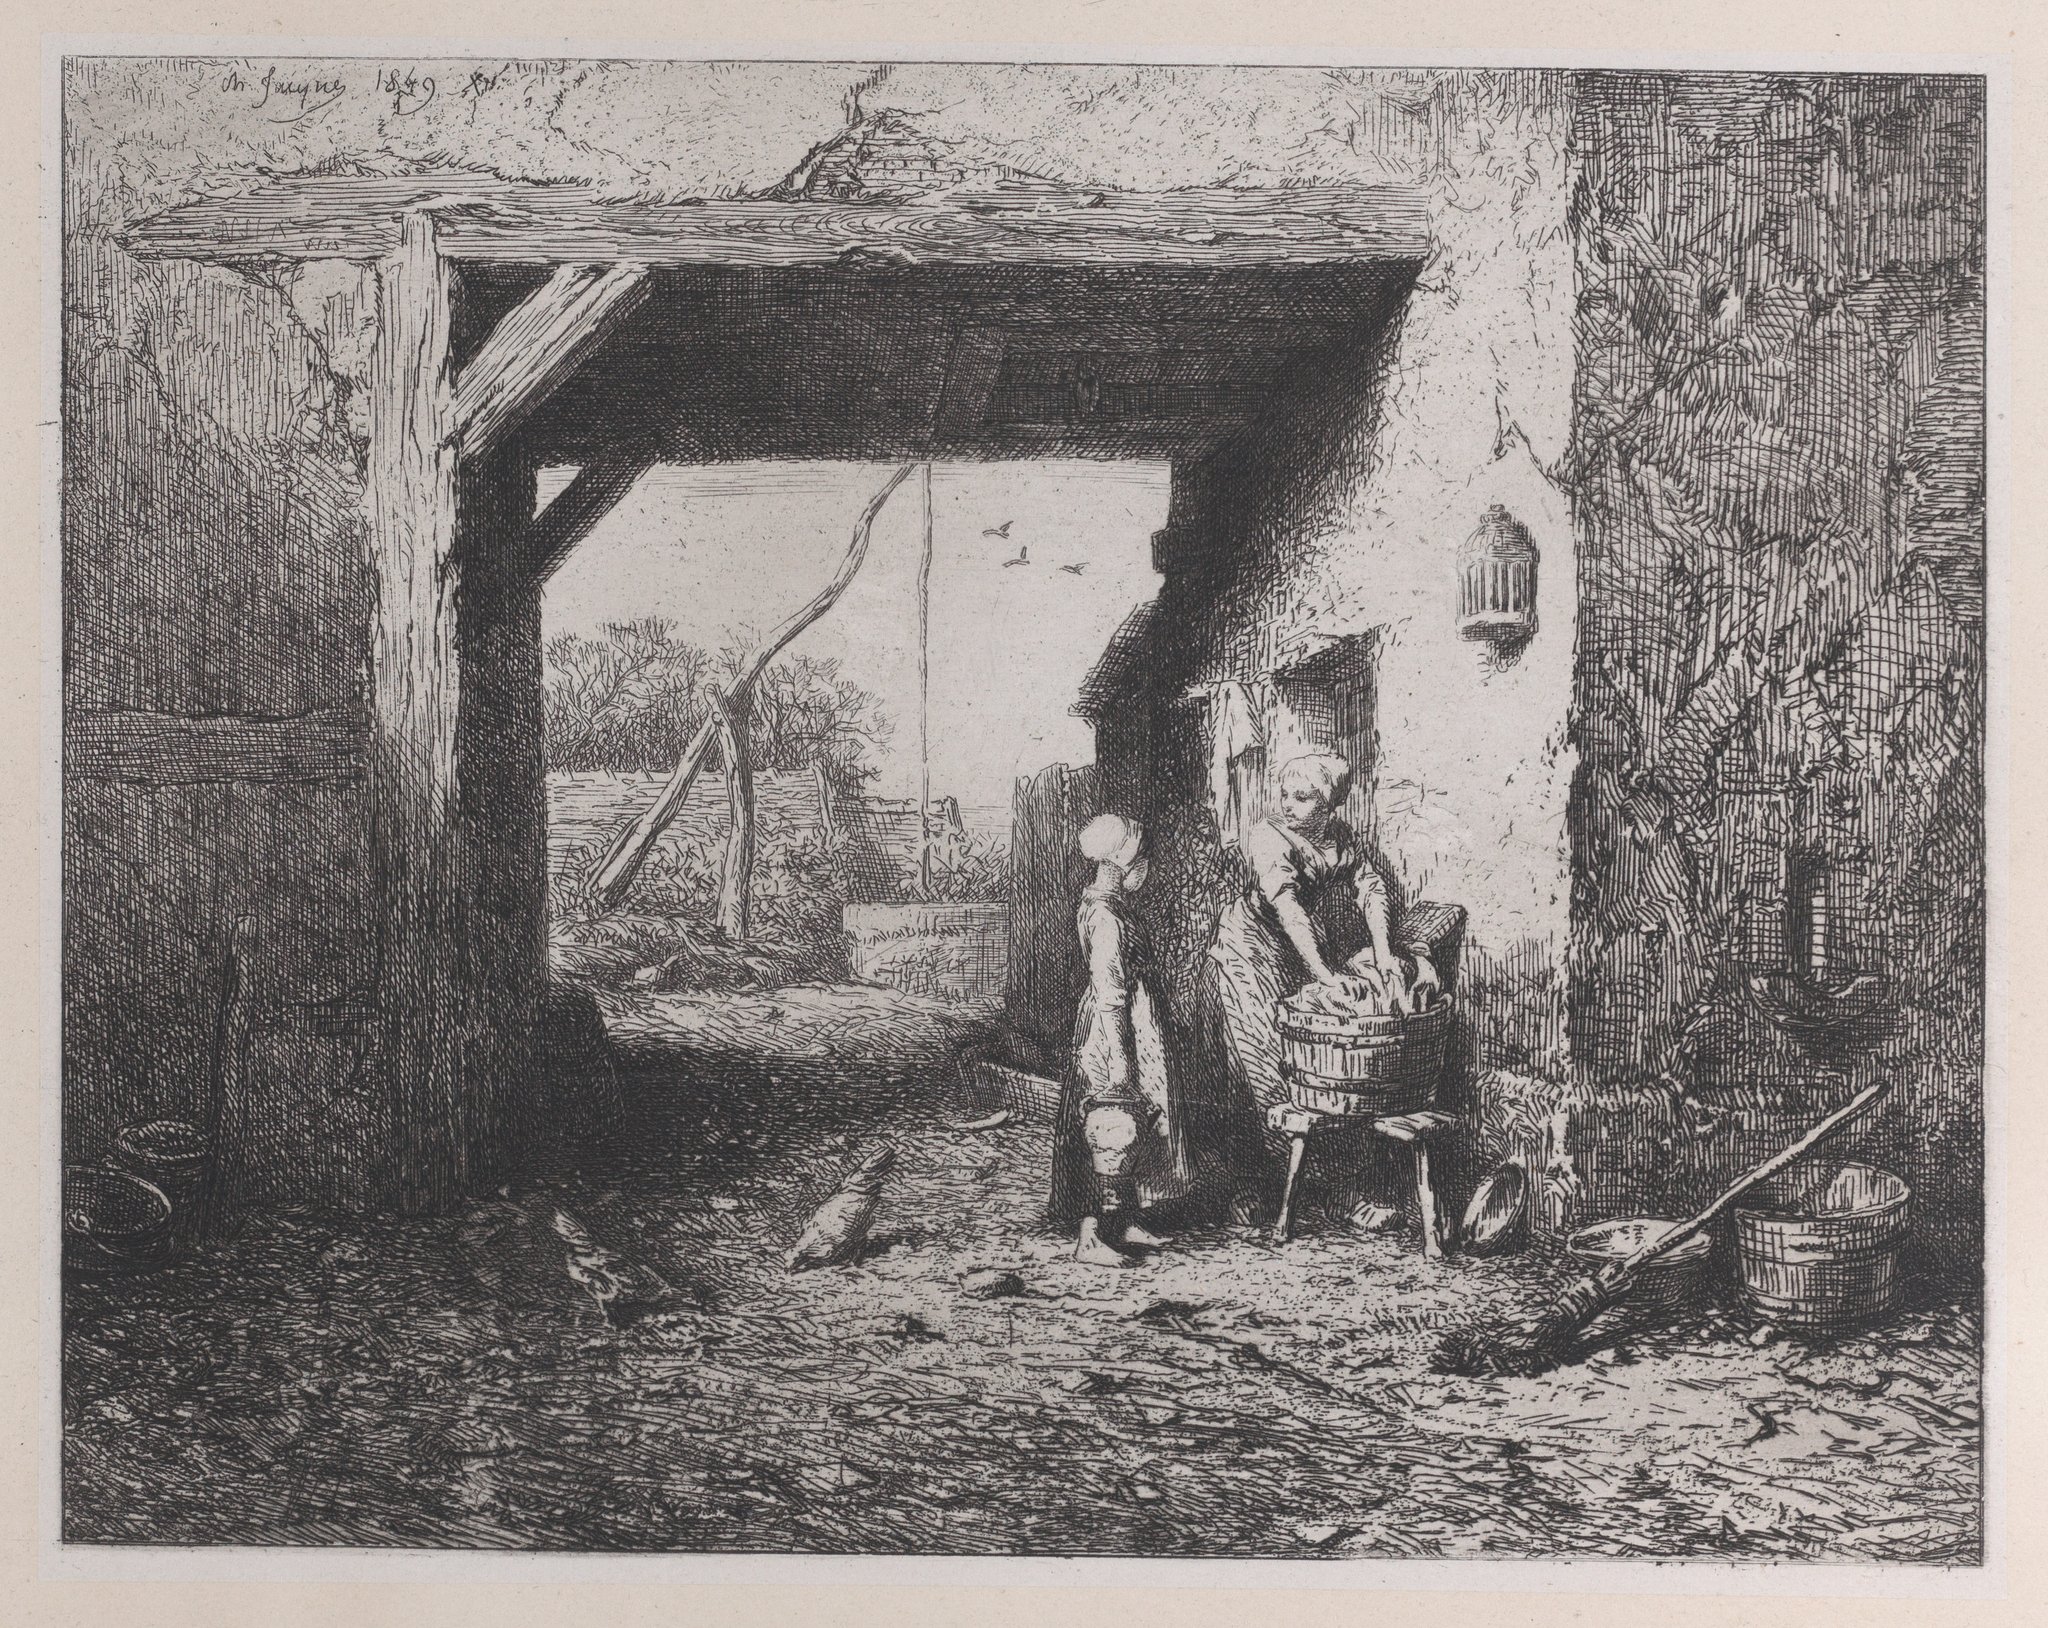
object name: print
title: Courtyard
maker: charles émile jacque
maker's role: artist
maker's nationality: french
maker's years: 1813-1894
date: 1849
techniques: etching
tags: girls,women,washing